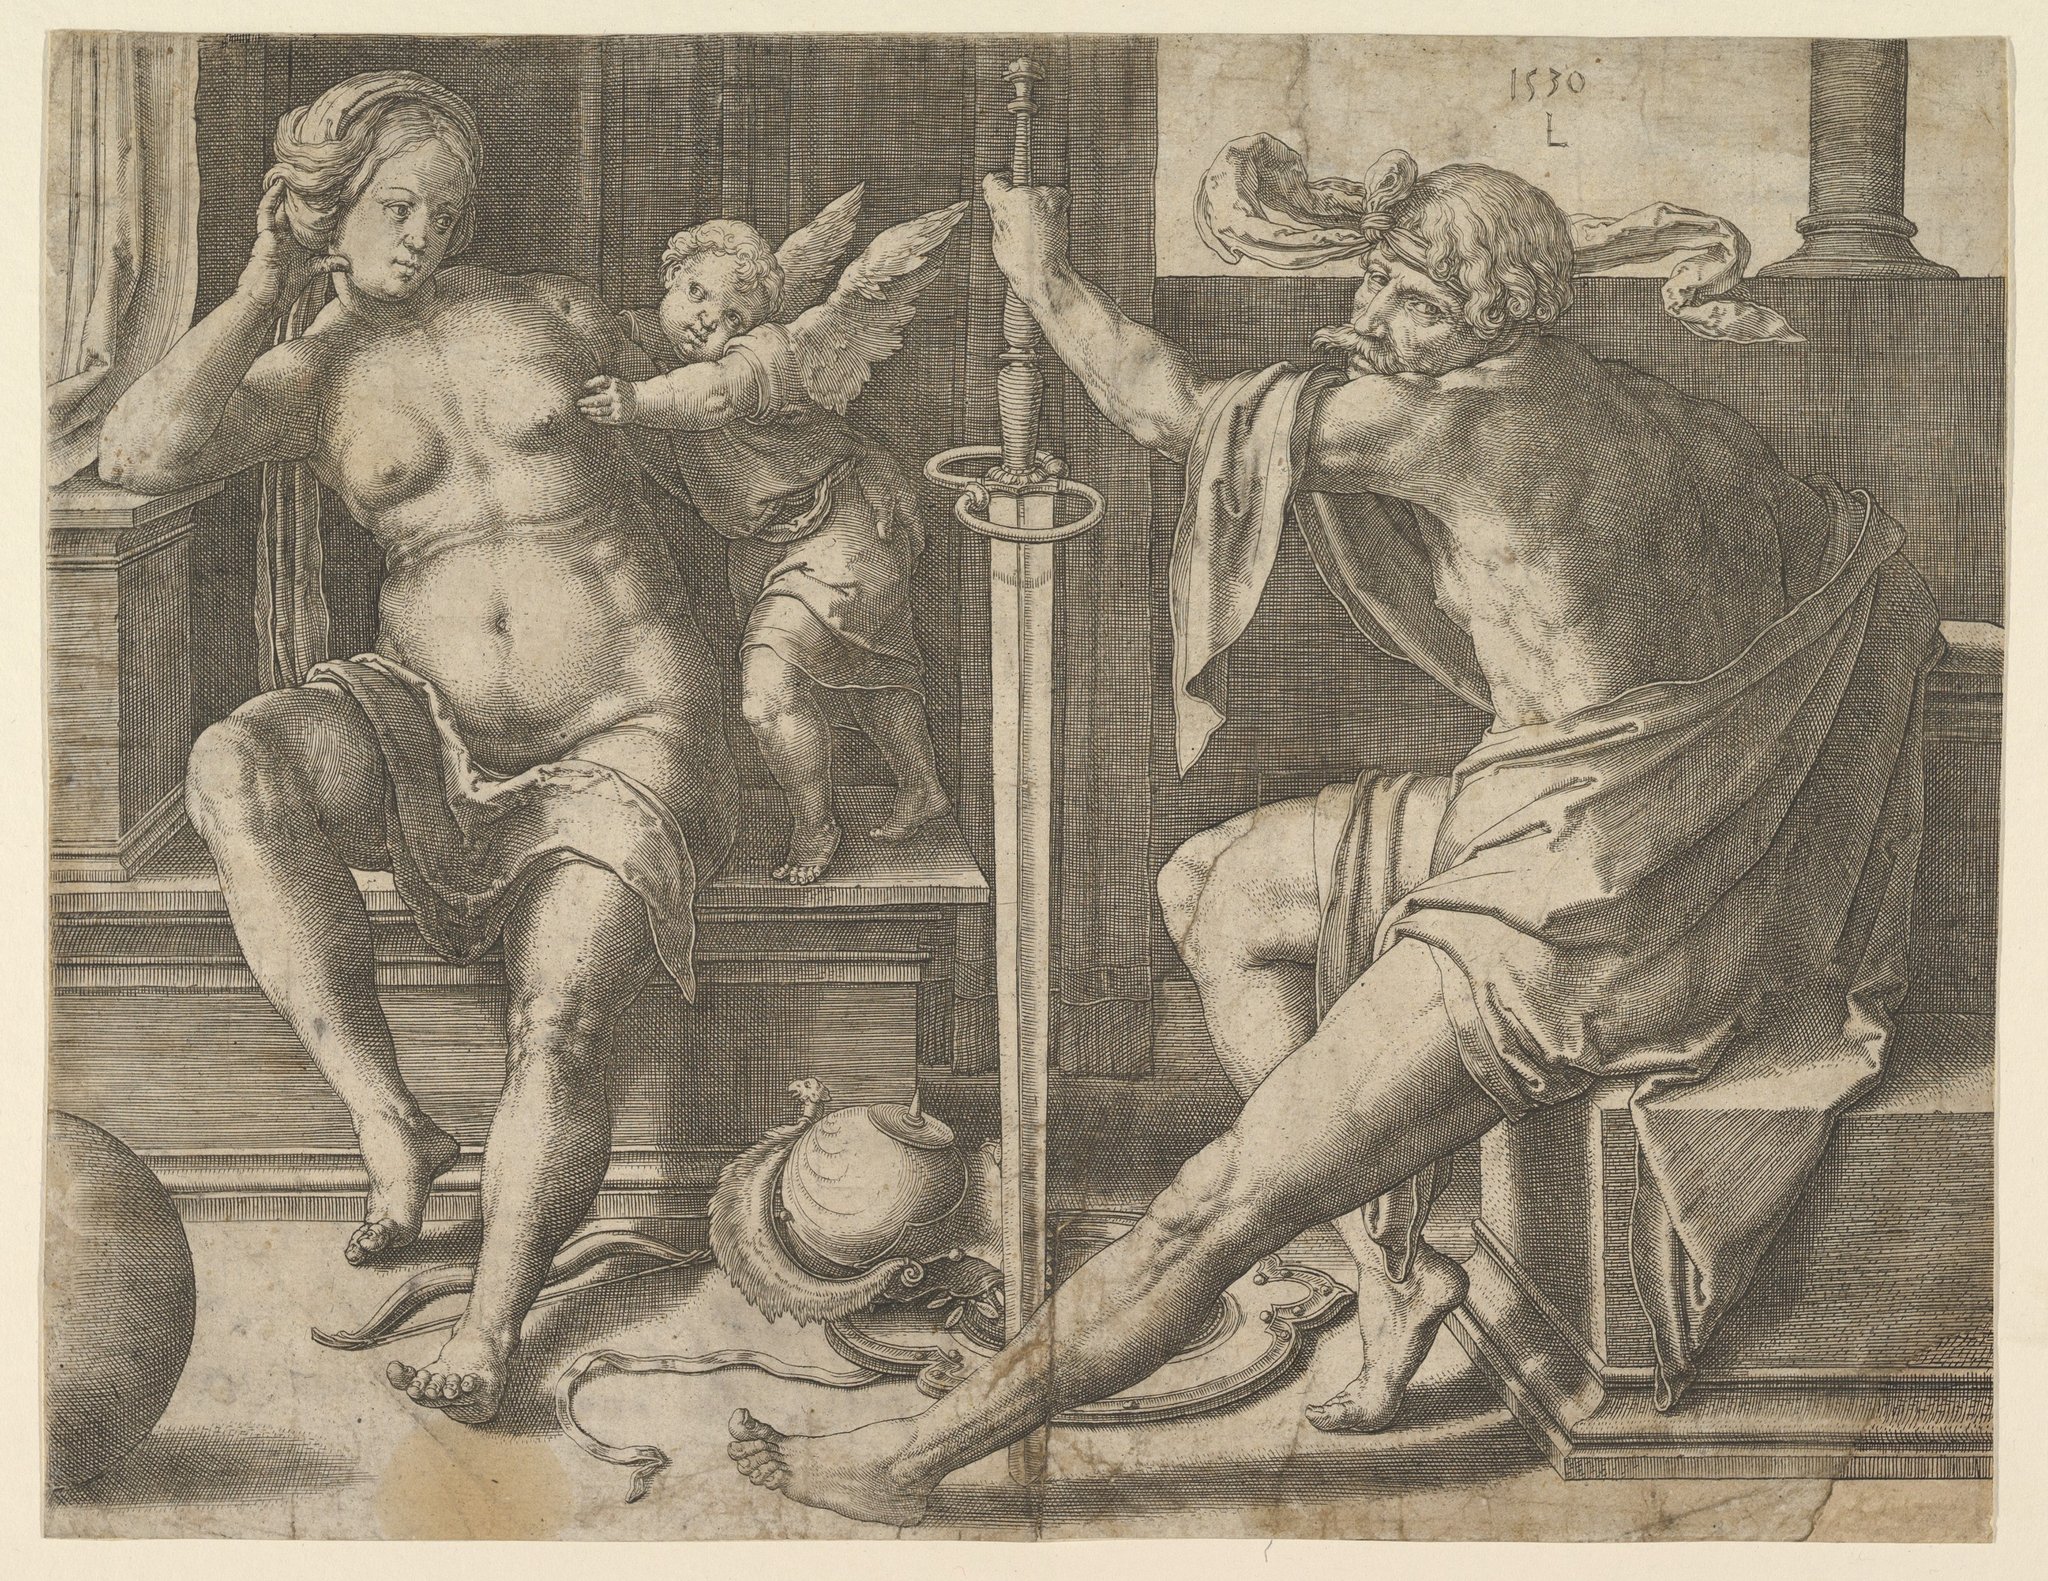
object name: print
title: Mars, Venus and Cupid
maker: lucas van leyden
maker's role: artist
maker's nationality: netherlandish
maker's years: 1494-1533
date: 1530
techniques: engraving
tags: cupid,mars,venus